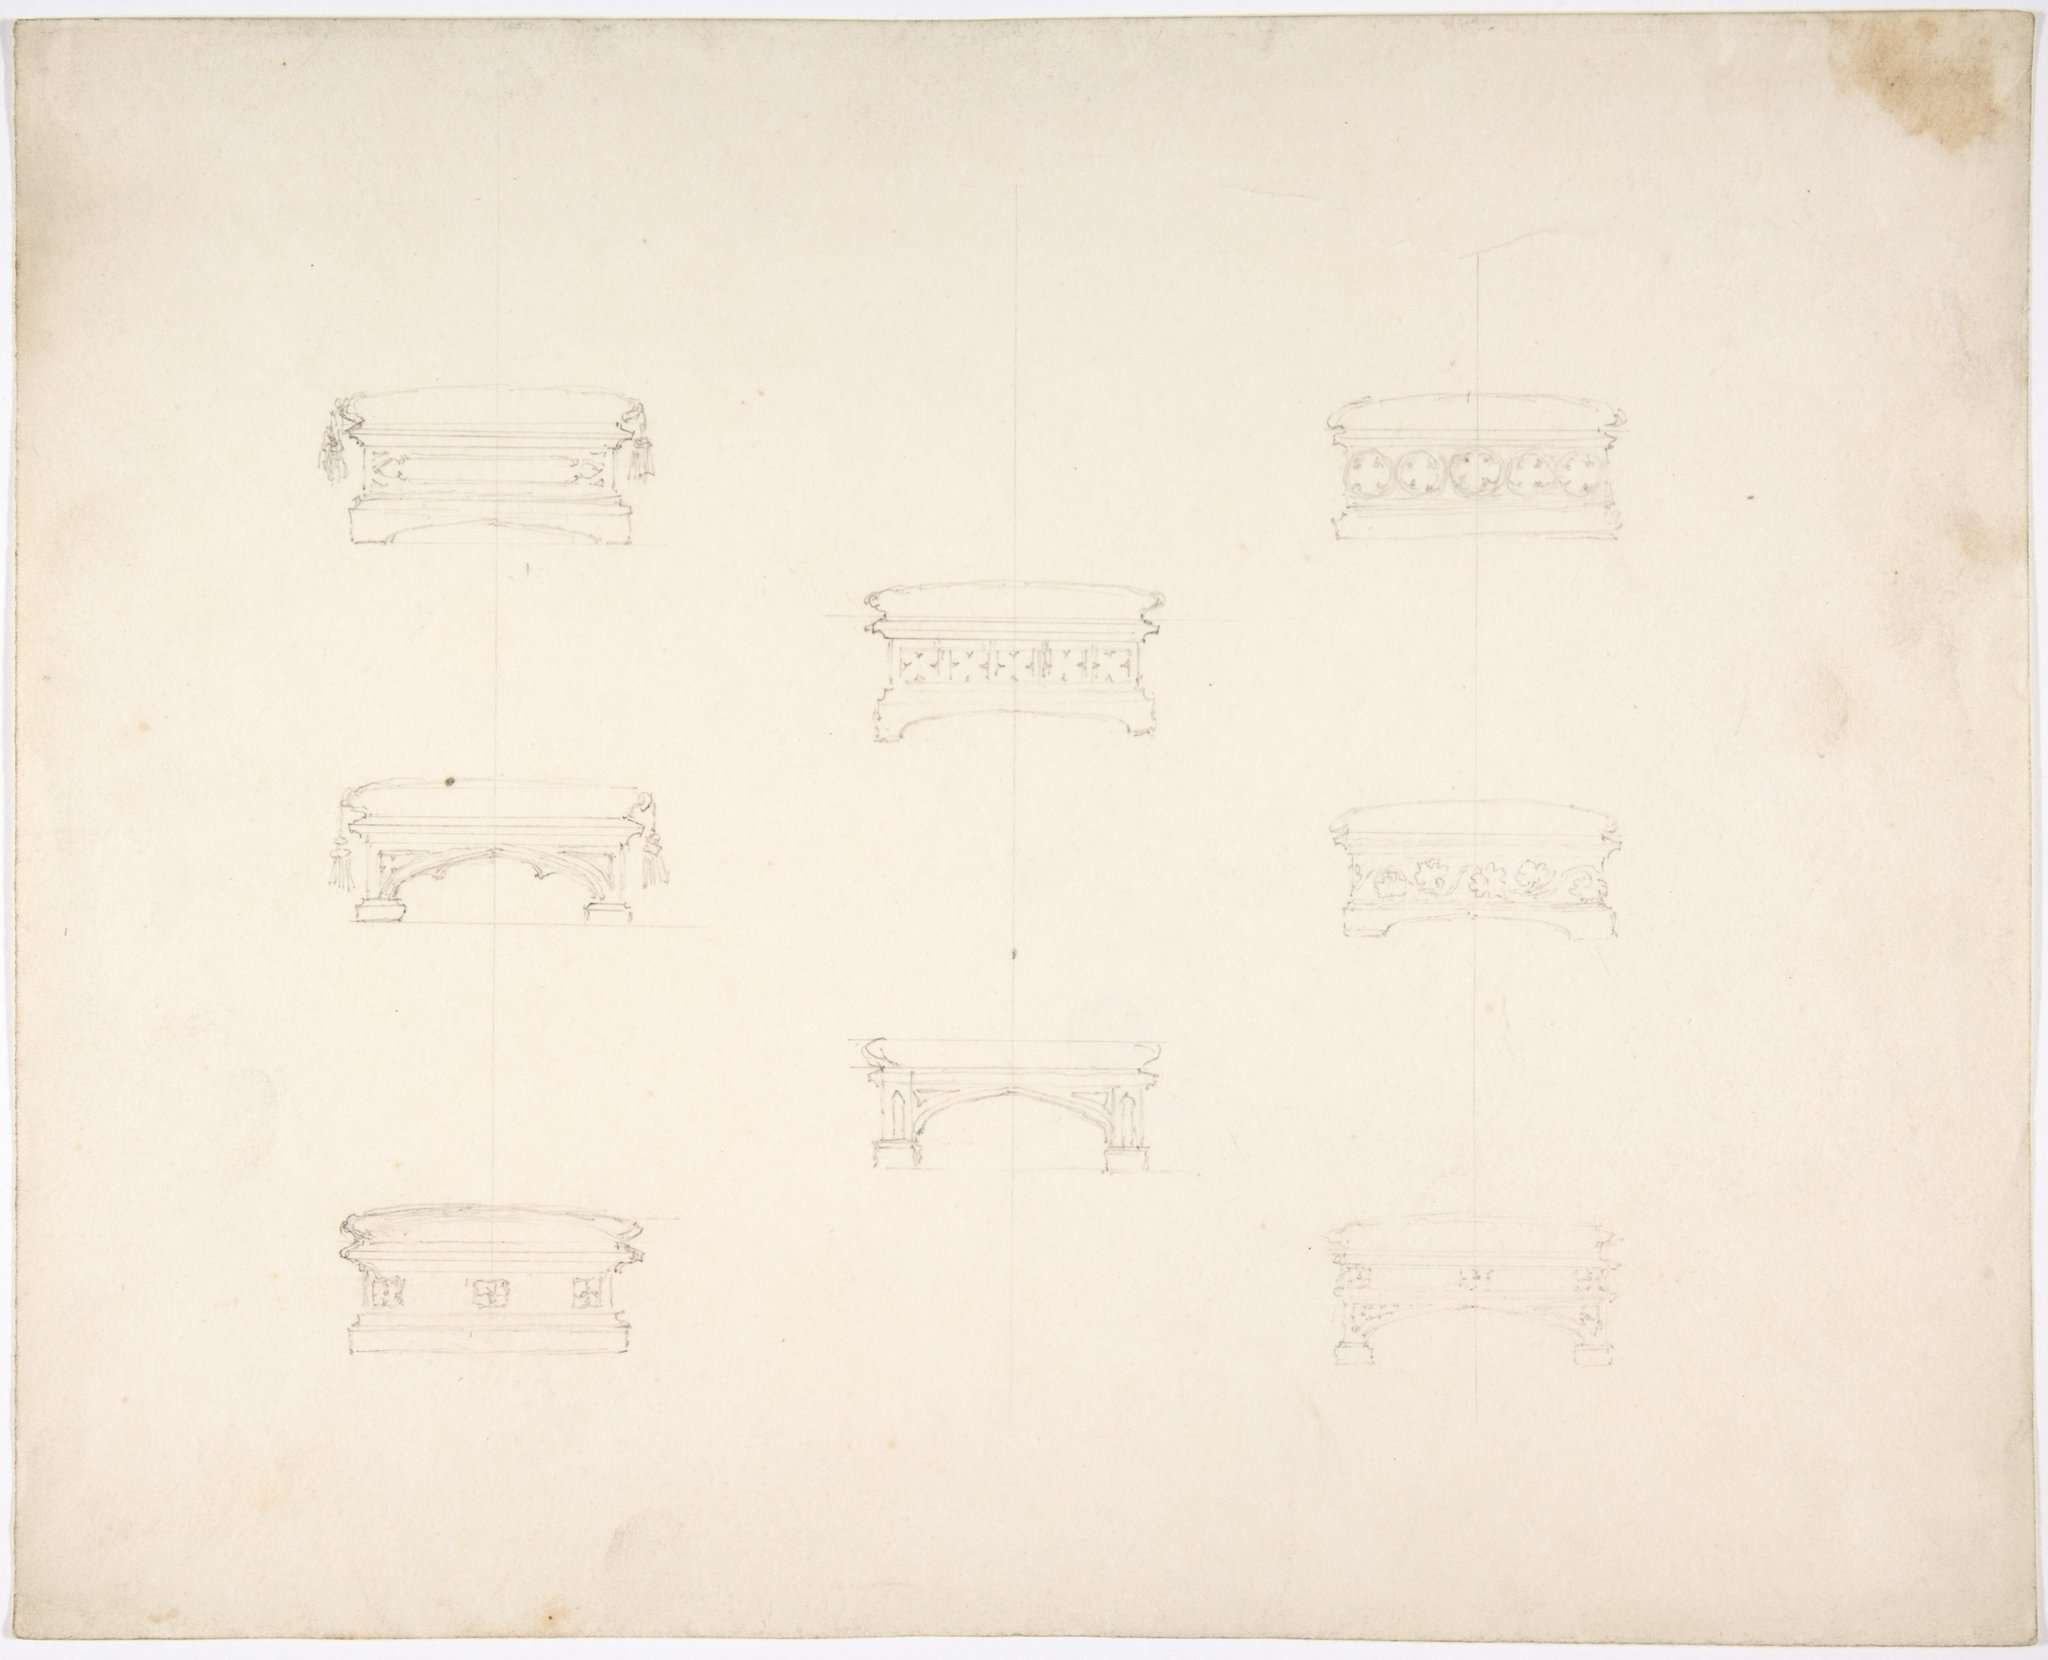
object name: drawing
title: Design for Eight Gothic Footstools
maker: anonymous, british, 19th century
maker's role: artist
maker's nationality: british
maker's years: 1800-1900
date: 1801-1833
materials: graphite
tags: stools